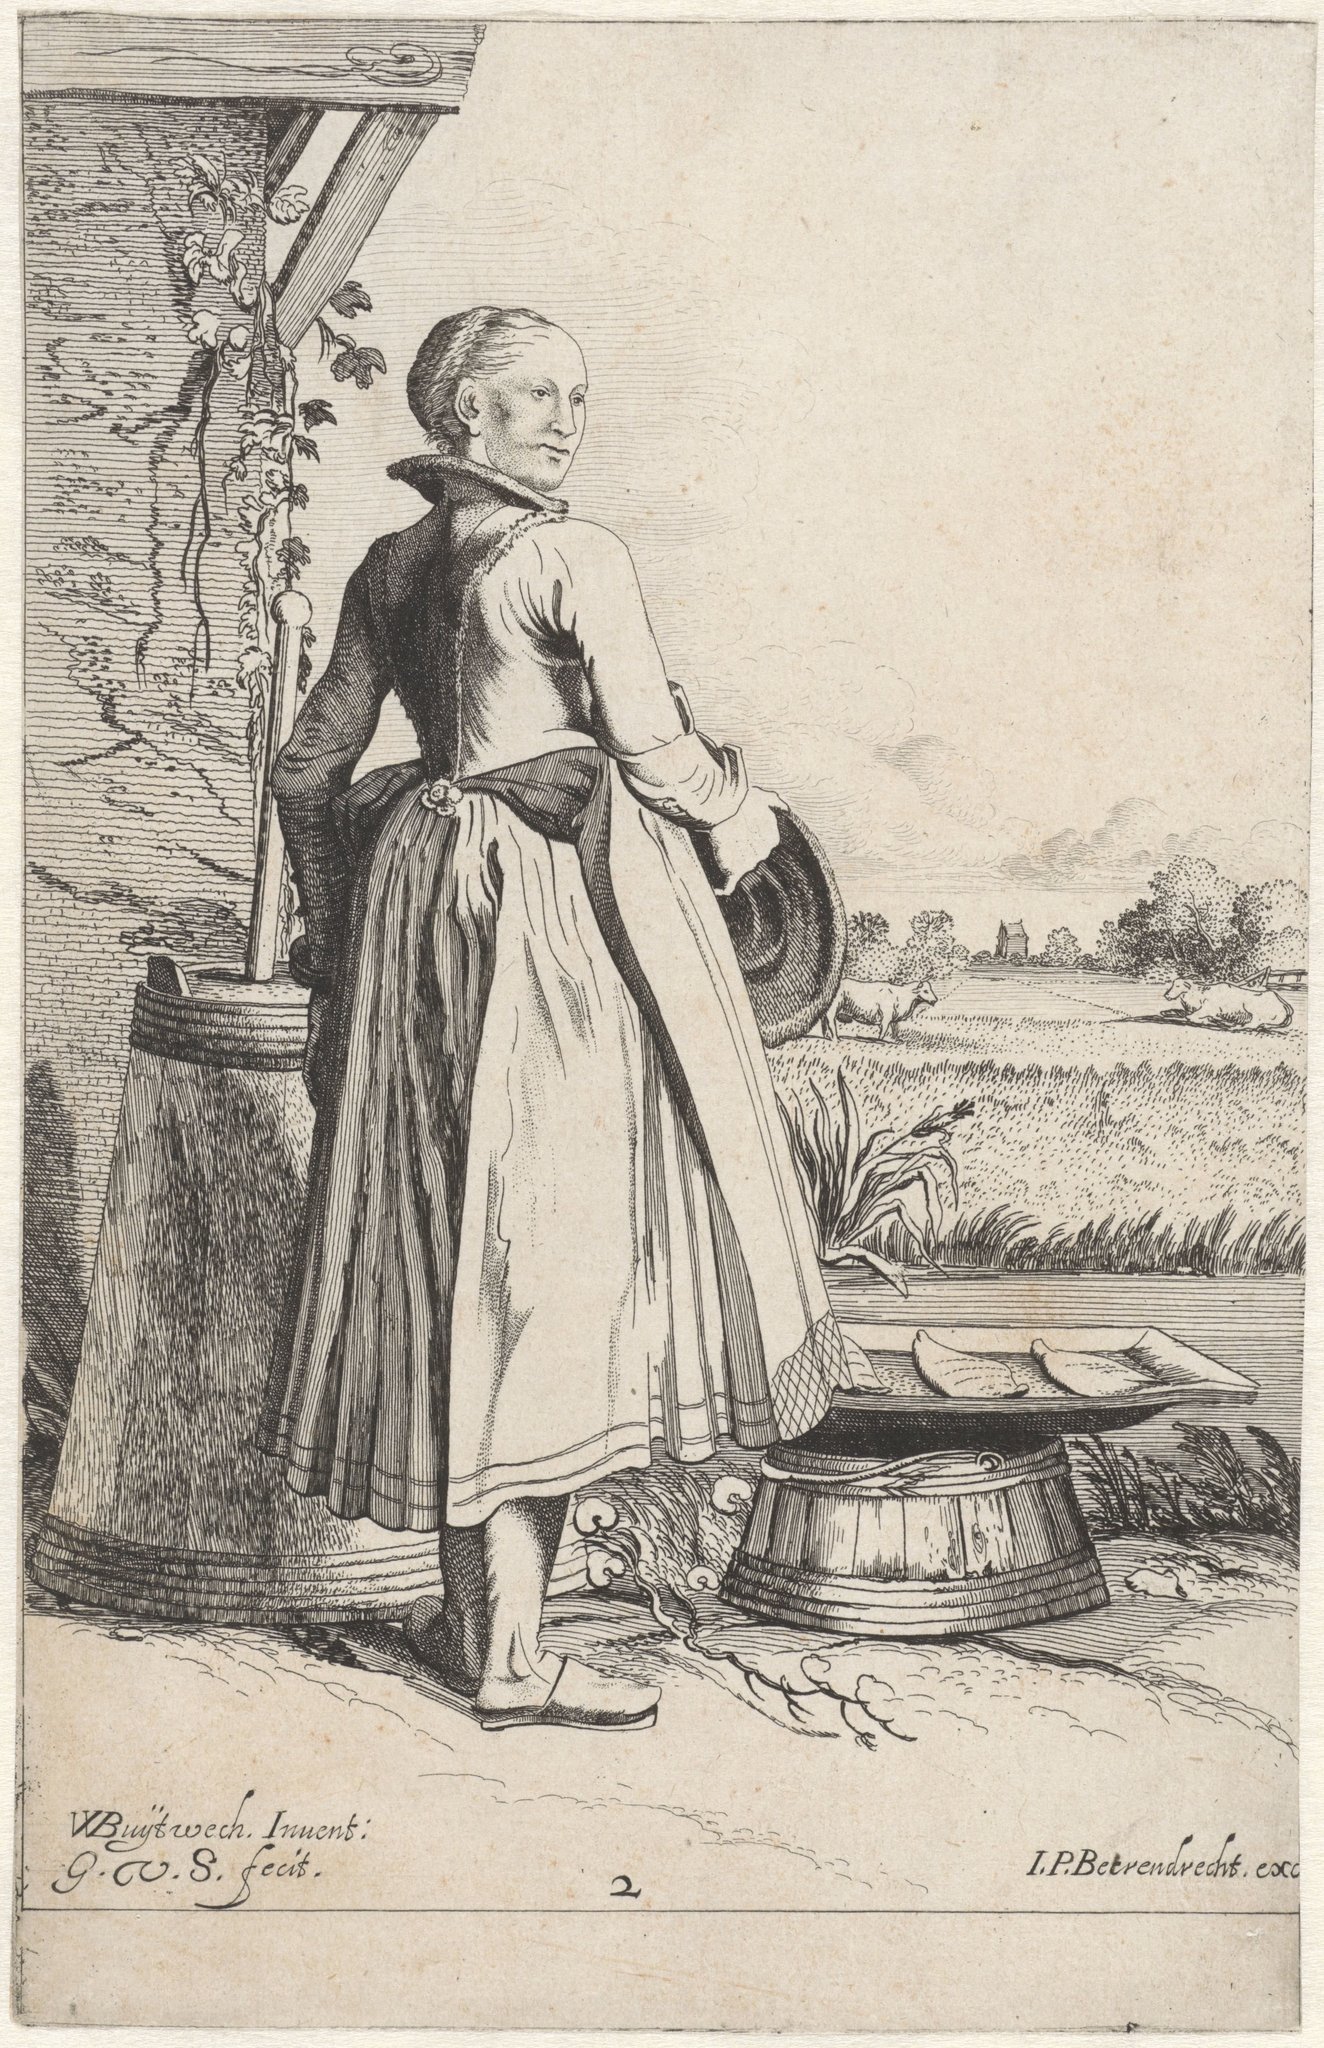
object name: print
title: Noord-Hollandse klederdrachten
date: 1620-1624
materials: paper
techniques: etching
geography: haarlem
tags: folk costume, regional costume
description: Naast een huis staat een jonge vrouw uit Edam, gekleed in klederdracht. Voor haar een vaart en een weide met koeien. De prent maakt deel uit van een serie van acht jonge vrouwen in Noord-Hollandse klederdrachten.